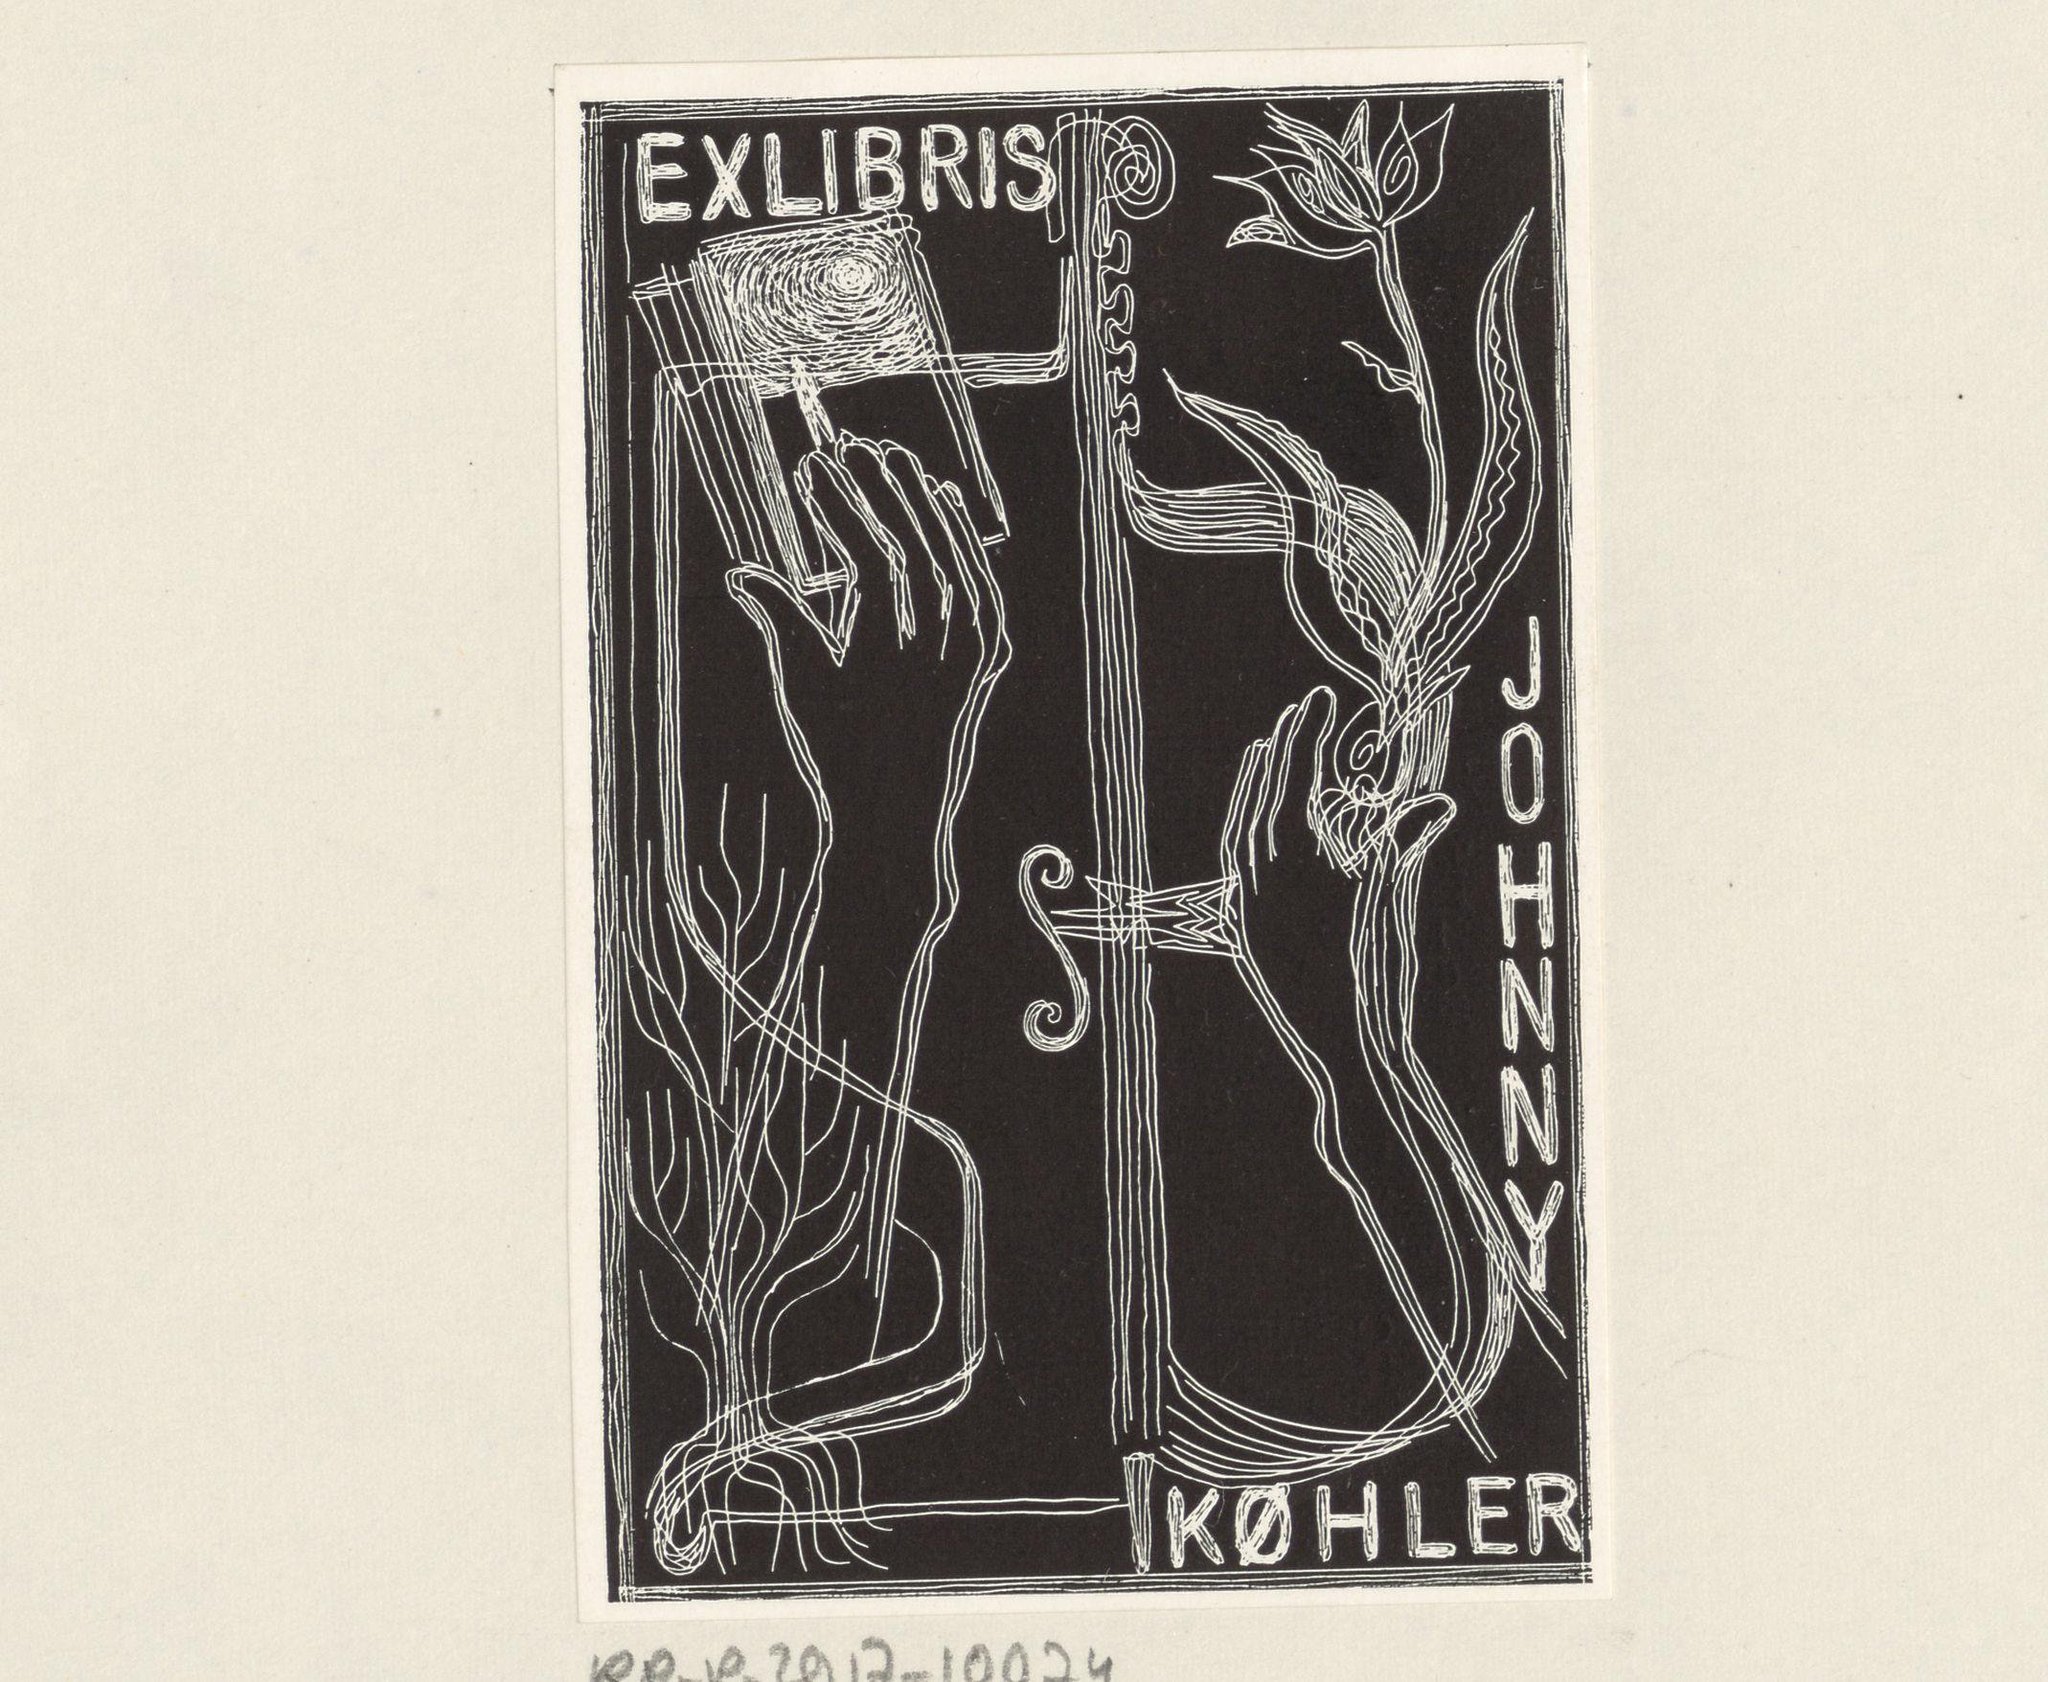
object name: bookplate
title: Ex libris van Johnny Køhler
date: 1957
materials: paper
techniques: printing block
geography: denmark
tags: flowers, lower arm, string instruments (bowed)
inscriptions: workshop stamp: ‘Muggi Wille-Nielsen/ Etching in zinc 1957’